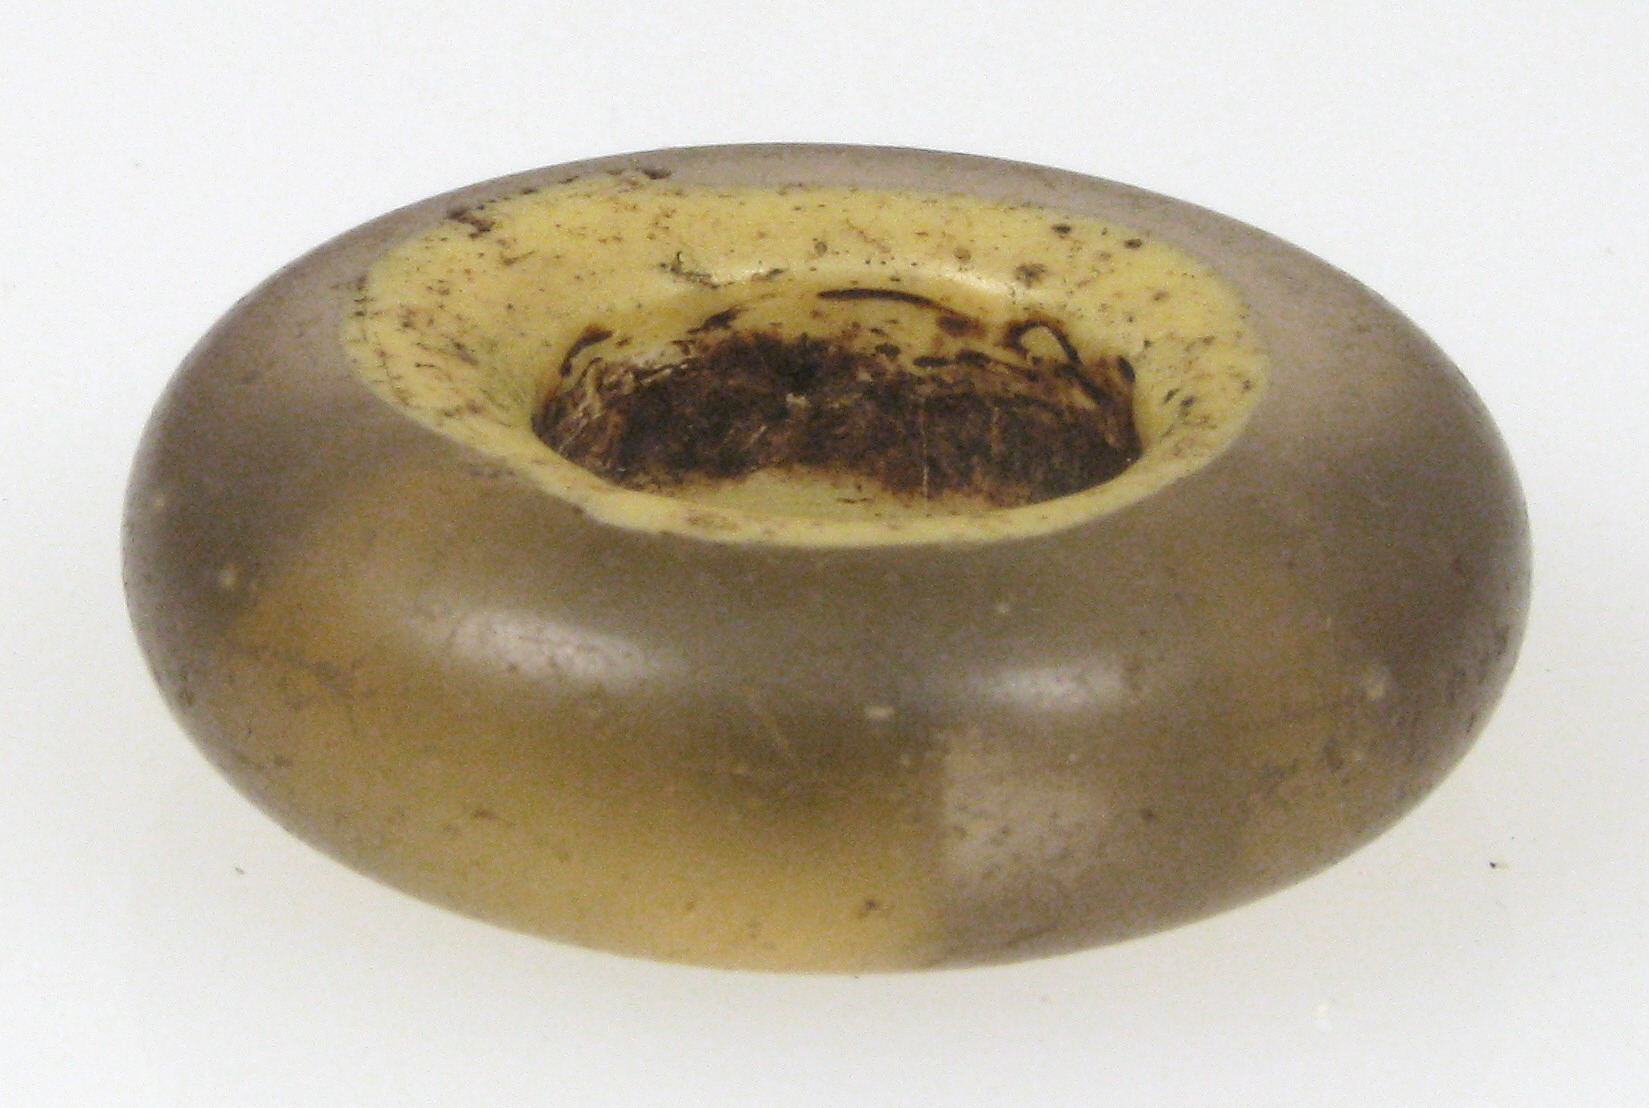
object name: bead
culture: frankish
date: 600-700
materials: glass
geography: germany